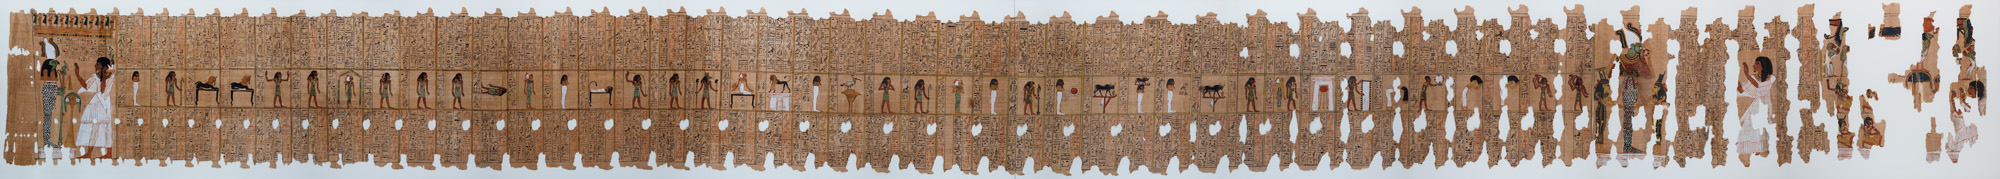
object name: papyrus, sethnakht, funerary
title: Funerary Papyrus of the Steward Sethnakht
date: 1320-1200 BCE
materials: ink, papyrus, pigment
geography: egypt